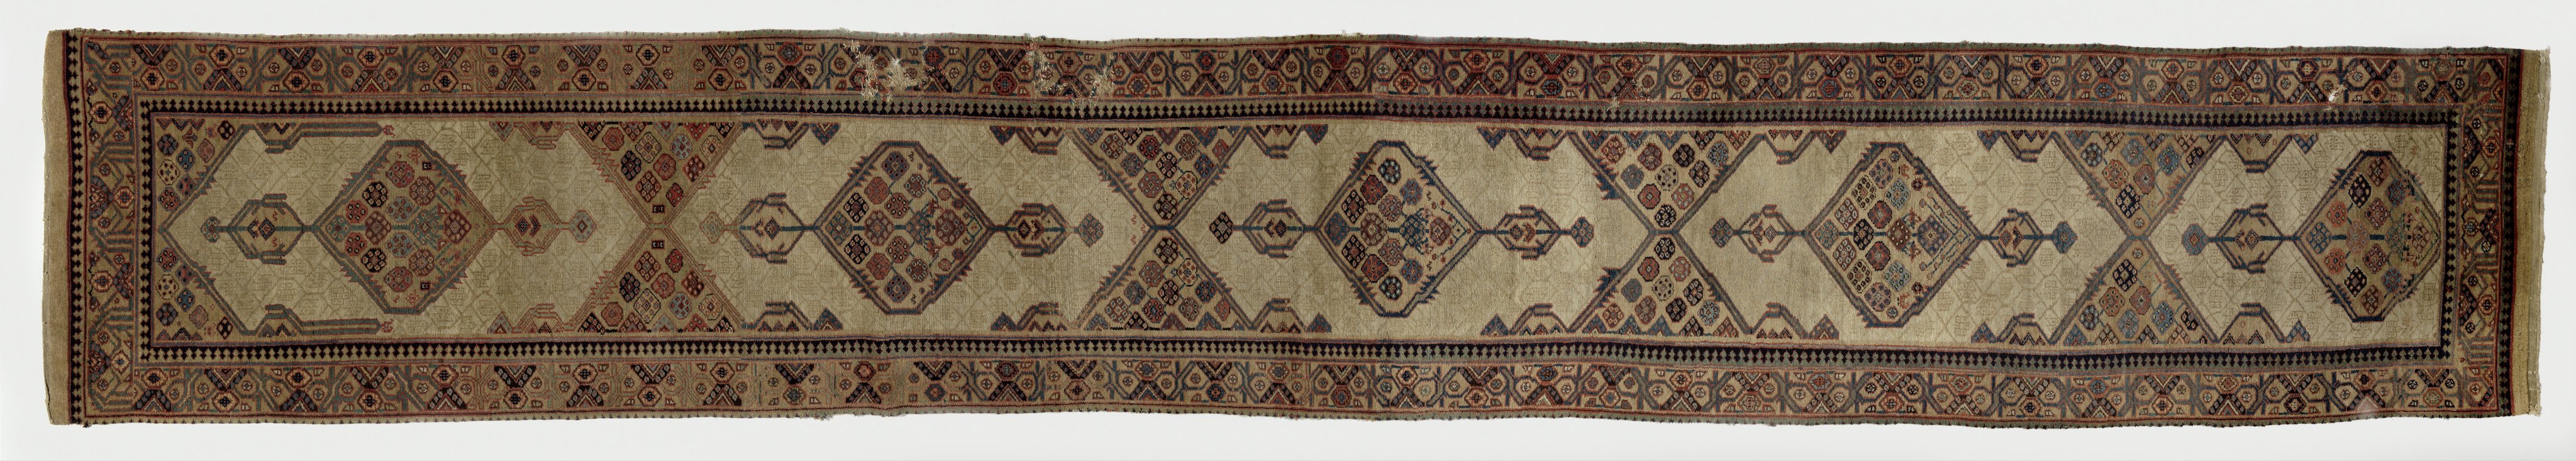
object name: oriental rug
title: Oosters tapijt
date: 1850-1900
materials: wool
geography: hamadan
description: Oosters tapijt van geknoopte wol, loperformaat. Op het middenveld staan twee medaillions met rasterwerk, rozetten en hartvormen. Rondom drie randen.